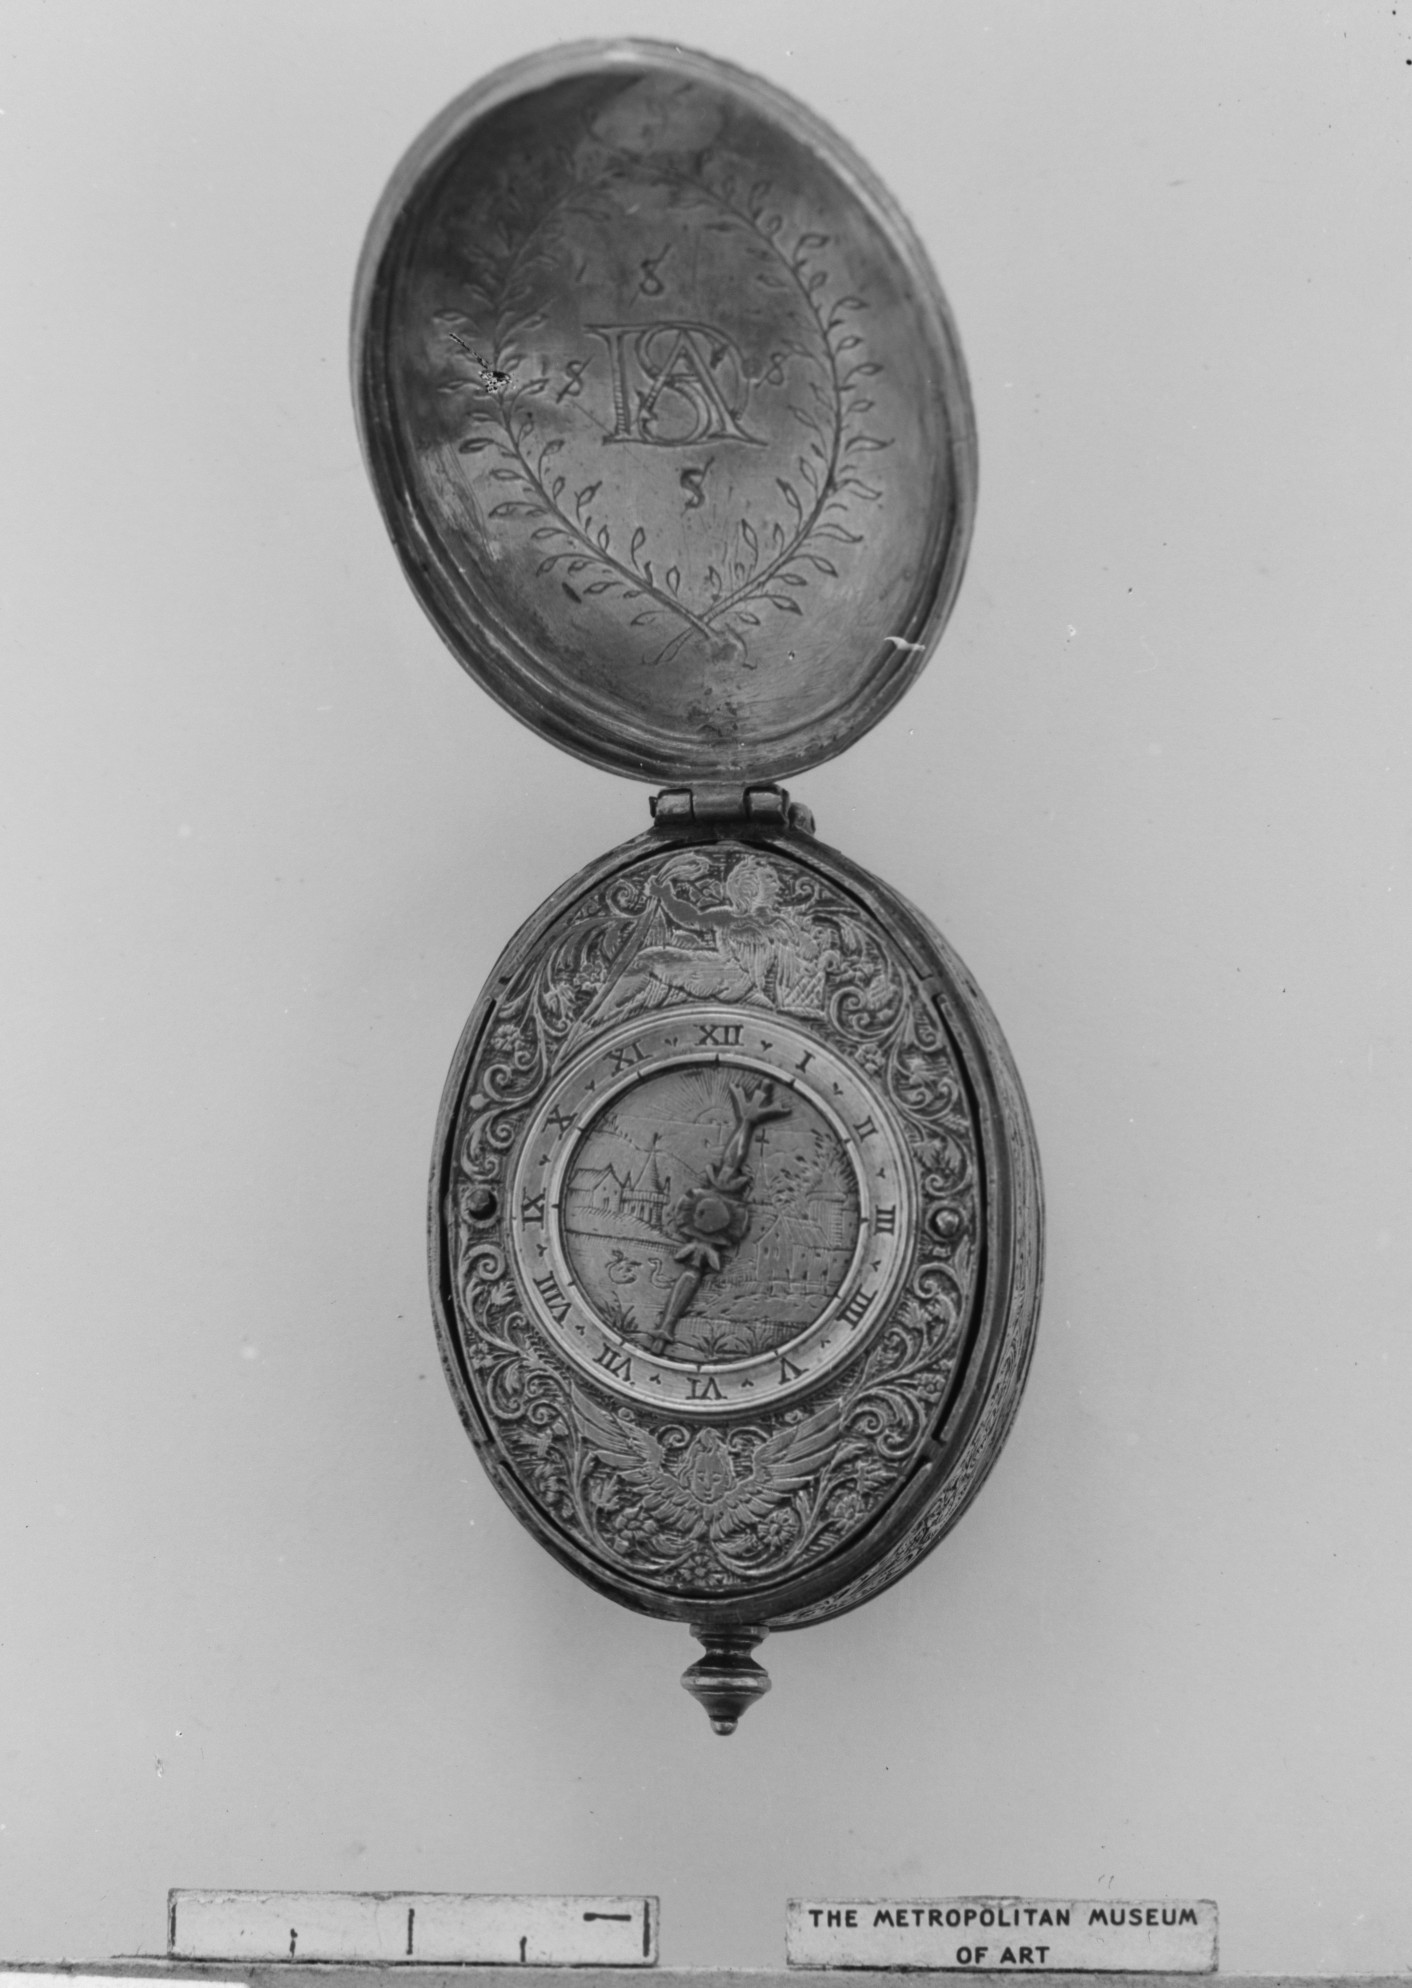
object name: watch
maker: jehan bénard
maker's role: maker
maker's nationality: french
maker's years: 1611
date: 1600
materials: metal